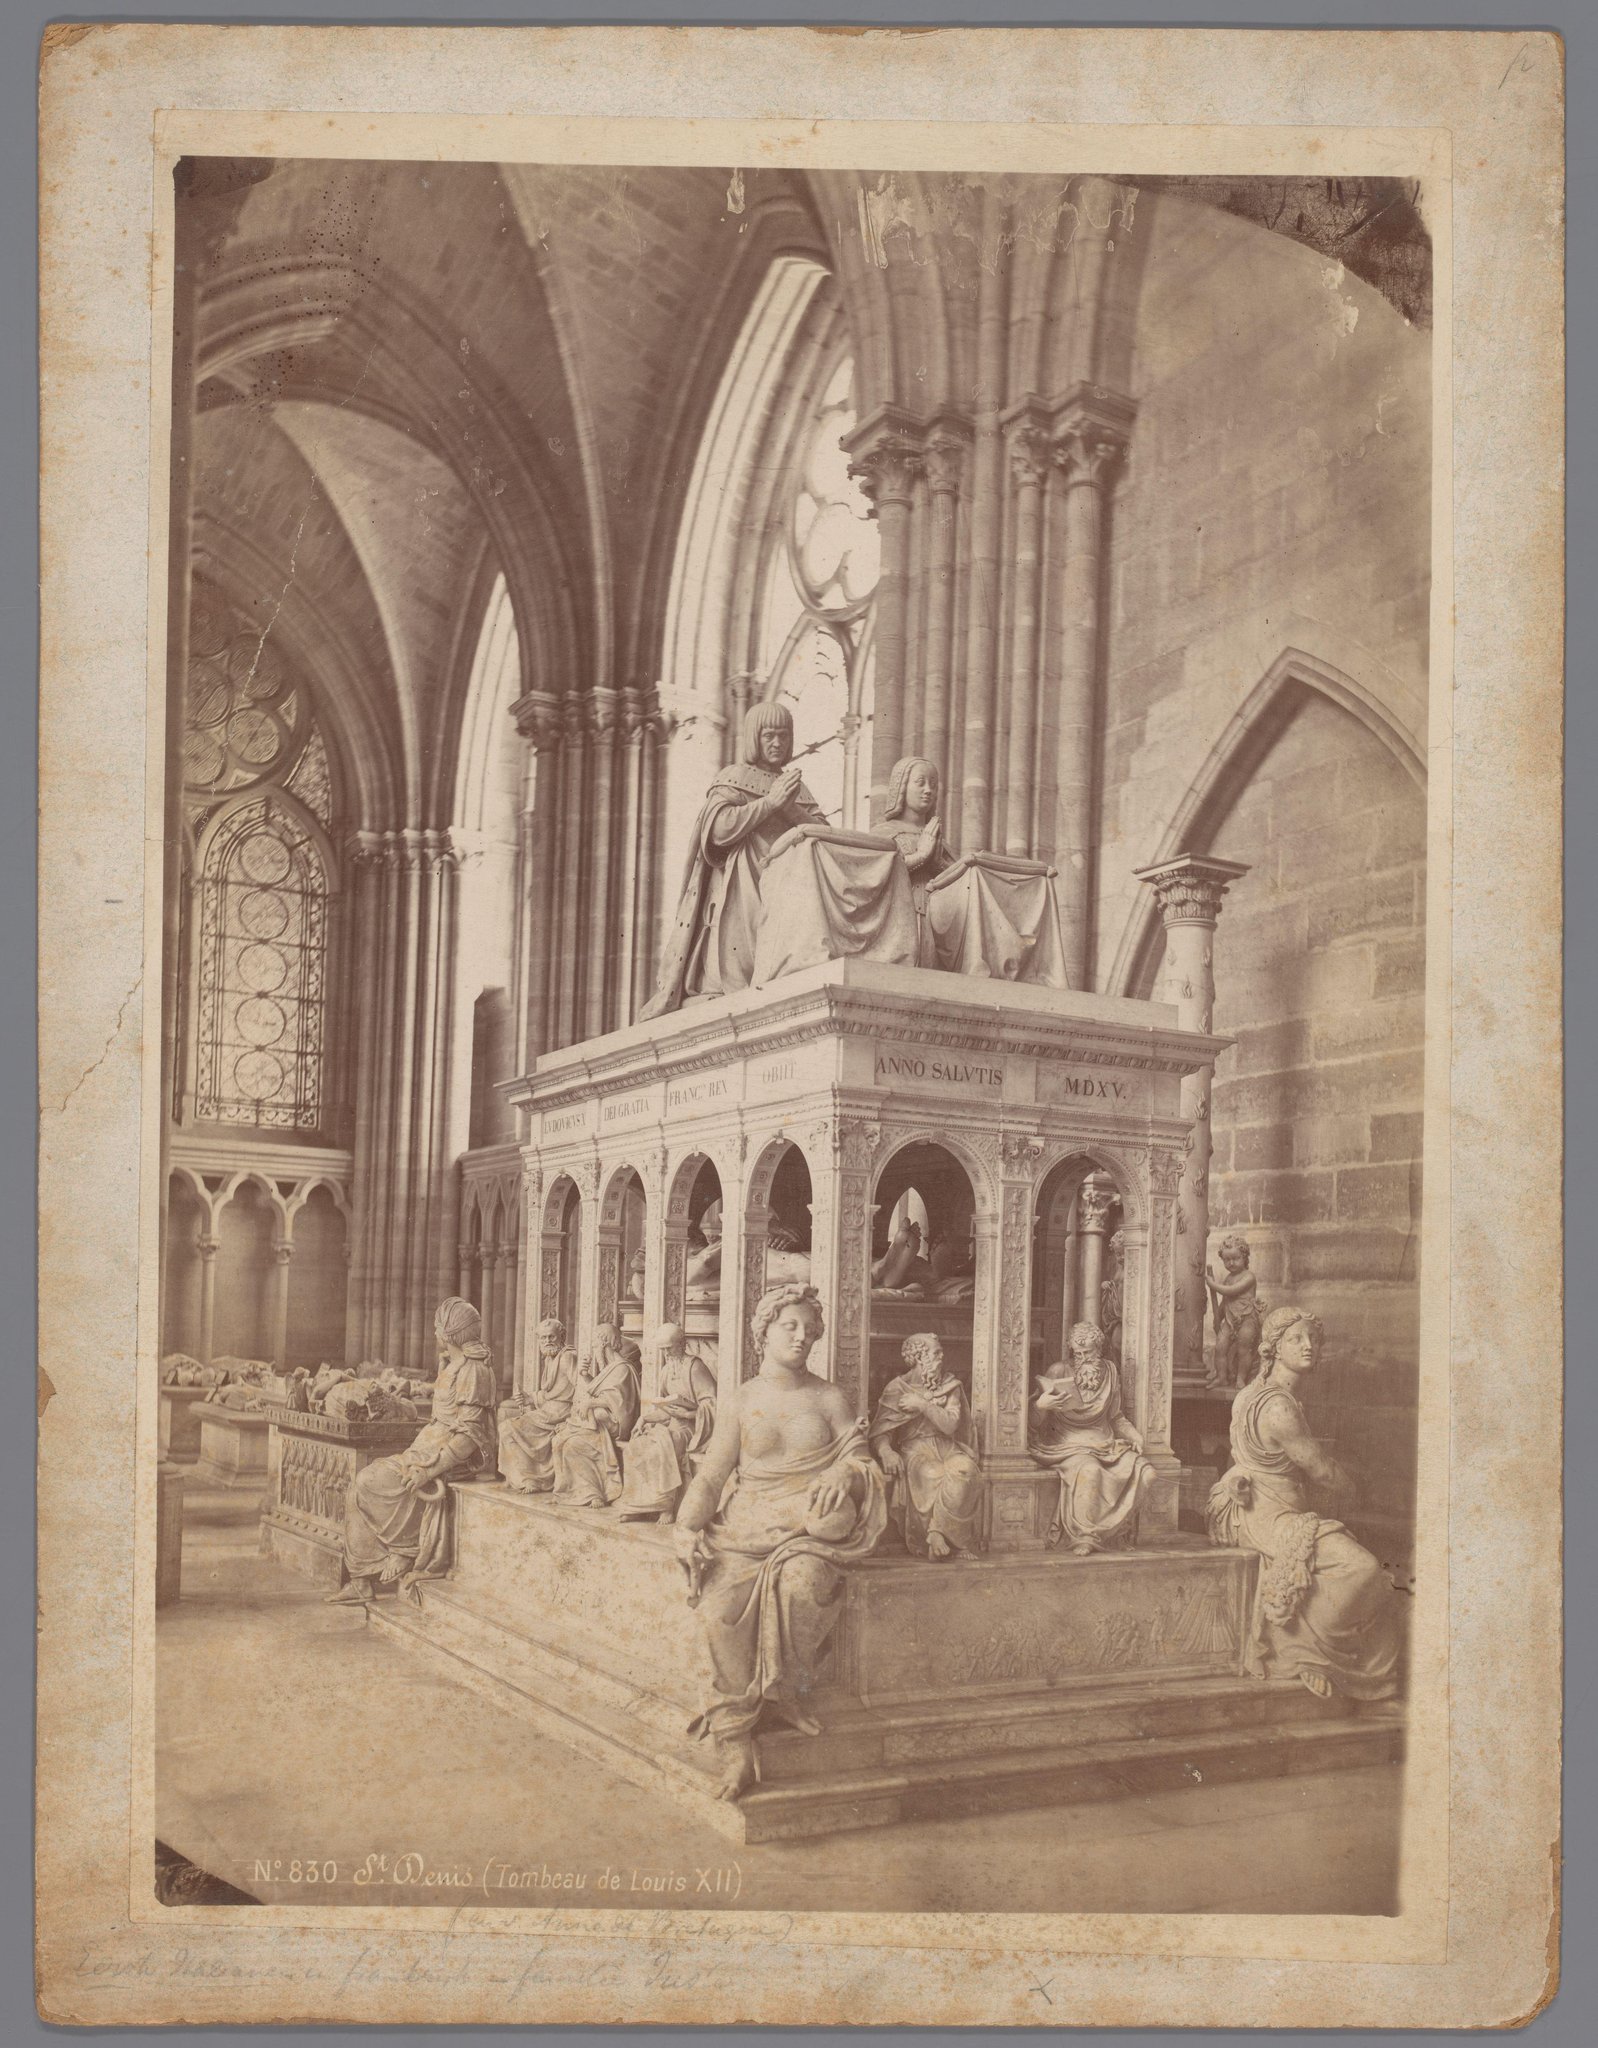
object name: photograph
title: St. Dennis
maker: séraphin-médéric mieusement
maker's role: fotograaf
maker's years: 1840-1905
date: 1850-1900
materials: cardboard, photographic support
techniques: albumen print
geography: saint-denis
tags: paris, grave, tomb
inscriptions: number: ‘No. 830’, workshop stamp: ‘MIEUSEMENT/ Photographe’, inscription: ‘[...]’, collector's mark: Lugt 3937